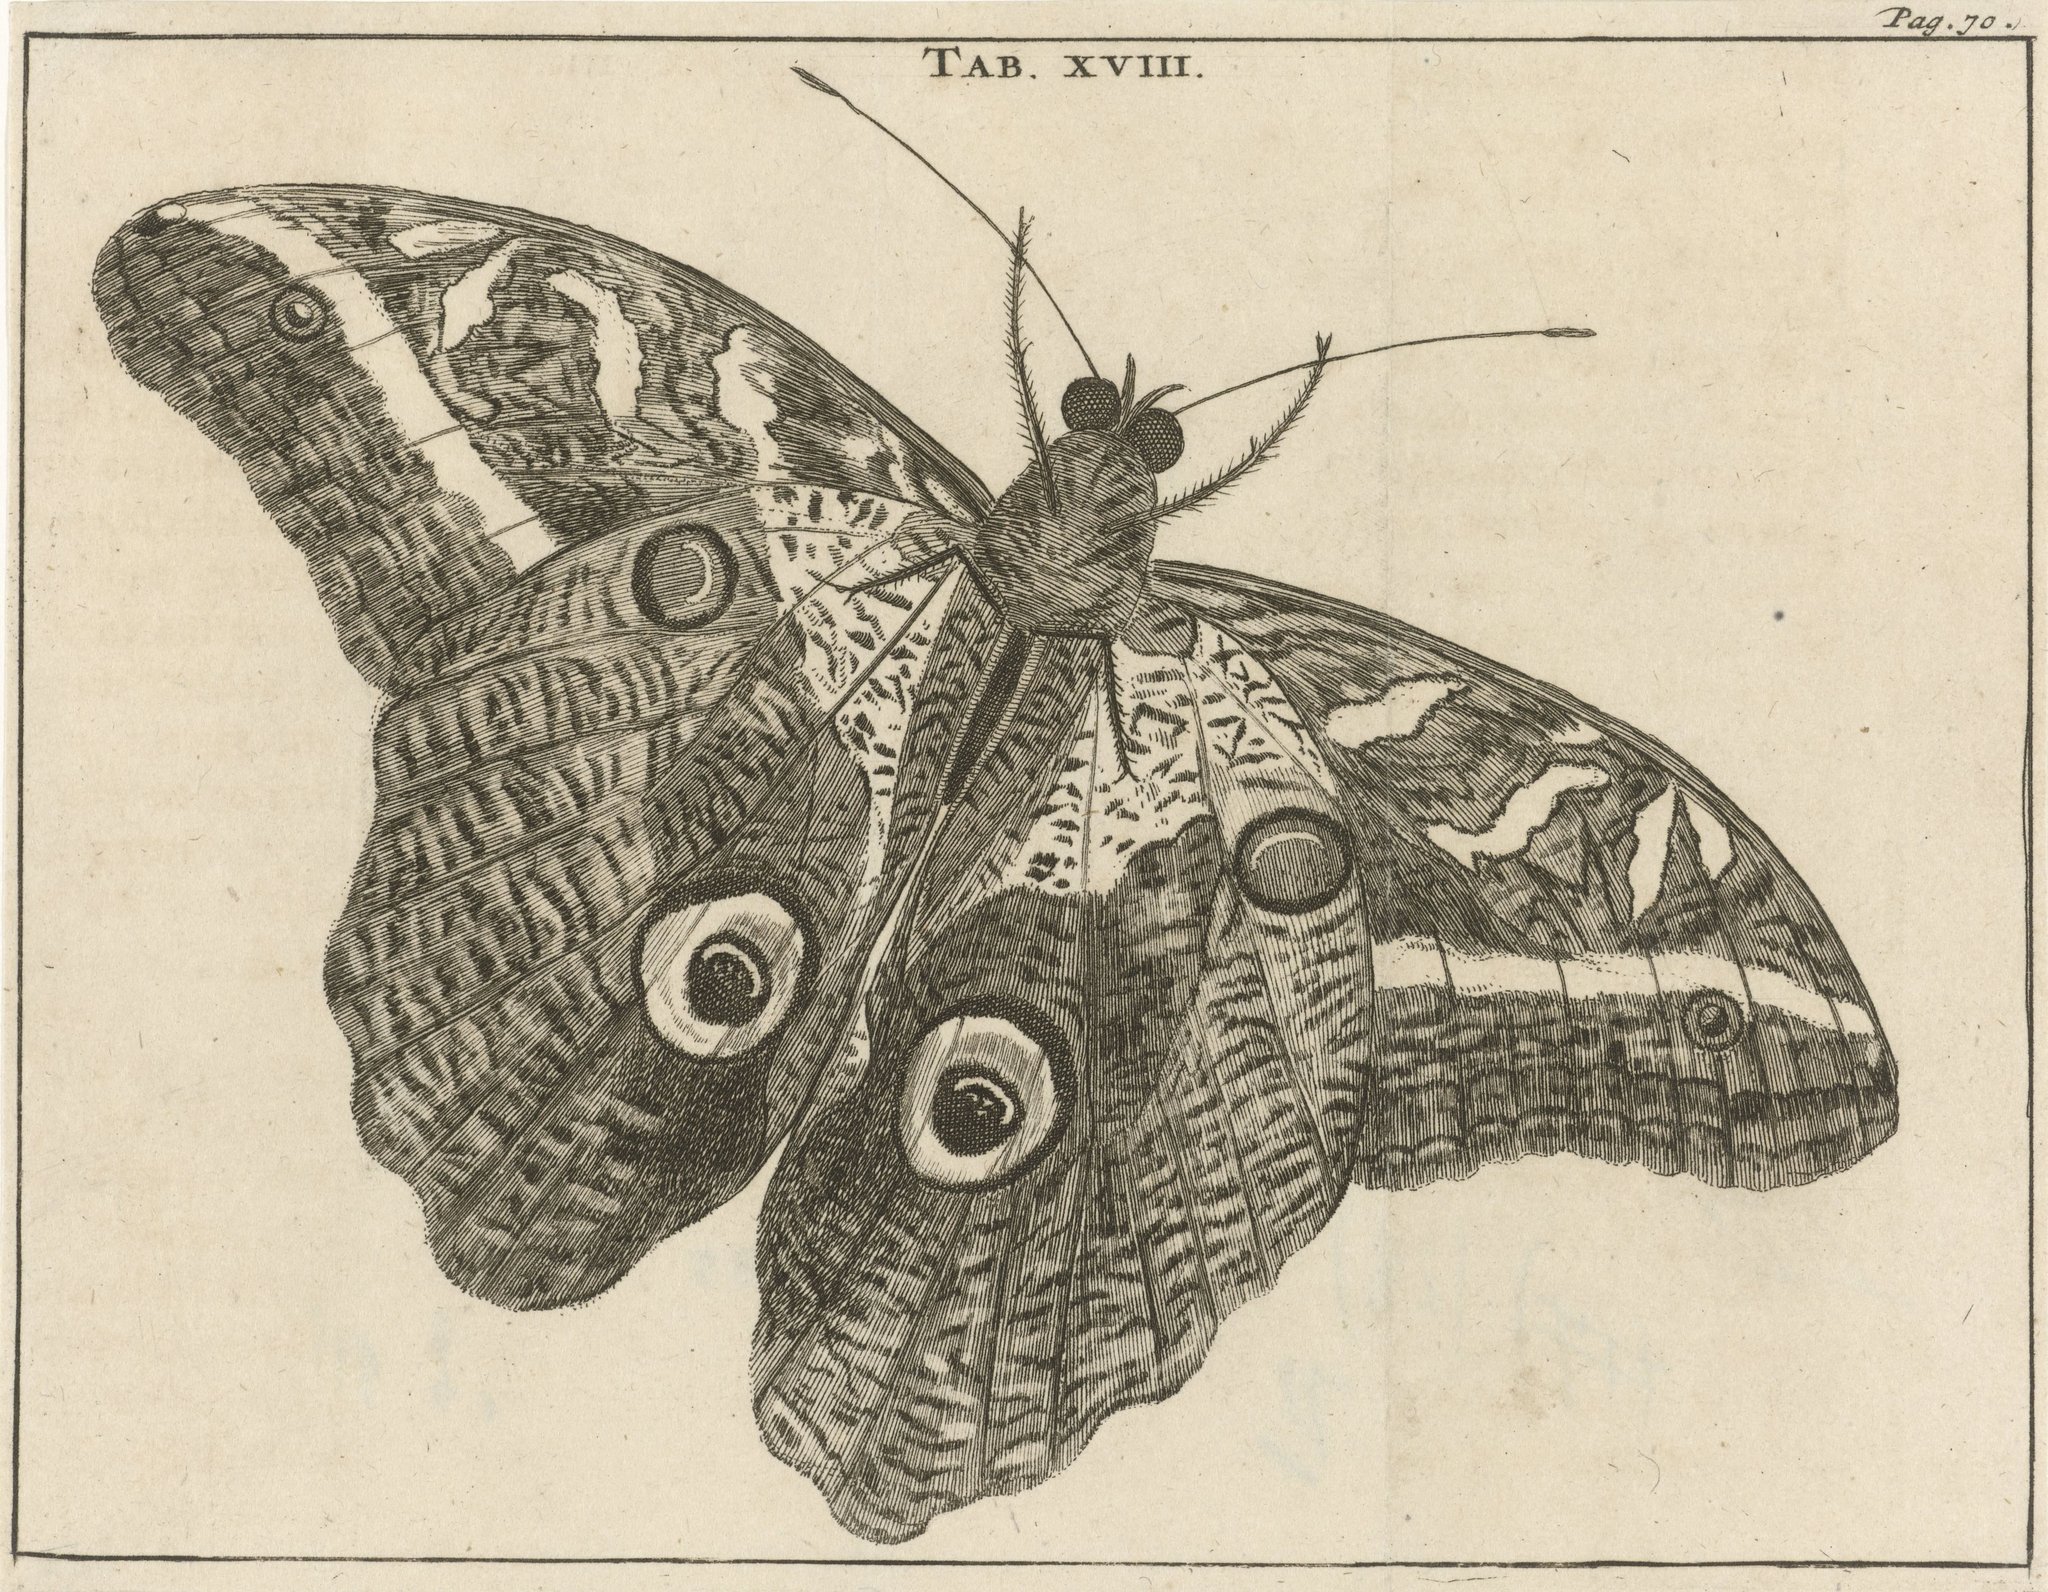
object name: print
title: Surinaamse reuzenvlinder XVIII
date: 1680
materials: paper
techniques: etching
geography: amsterdam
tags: insects: butterfly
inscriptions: collector's mark: Lugt 2228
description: Illustratie opgenomen in: Blankaart, Steven. Schou-burg der rupsen, wormen, ma'den, en vliegende dierkens daar uit voortkomende. Amsterdam: Jan Claesz ten Hoorn, 1680.